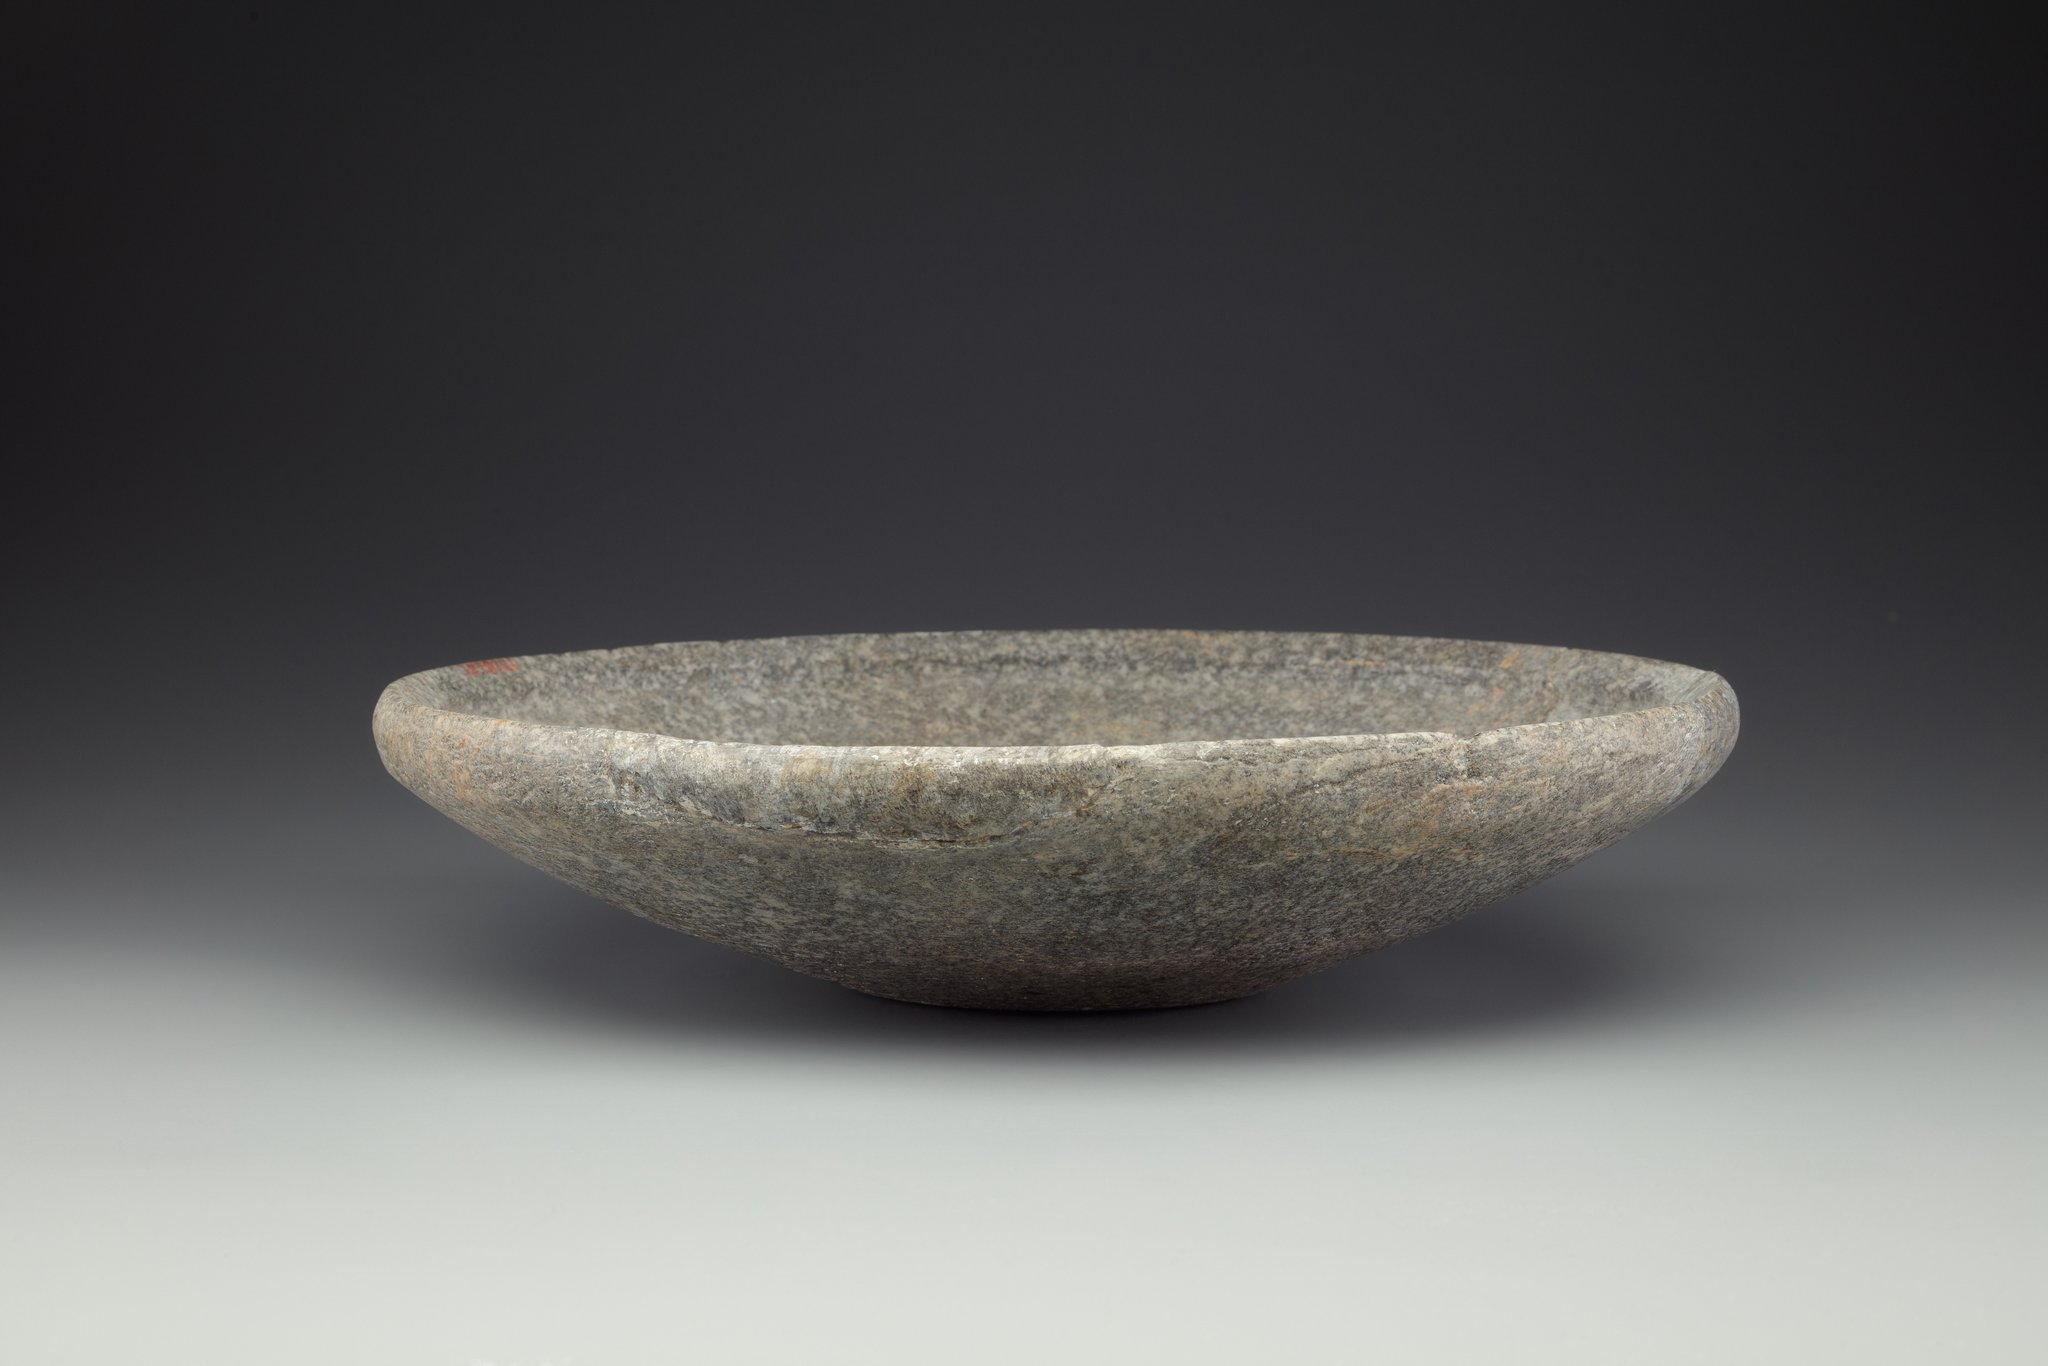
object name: dish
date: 3100-2649 BCE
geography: egypt